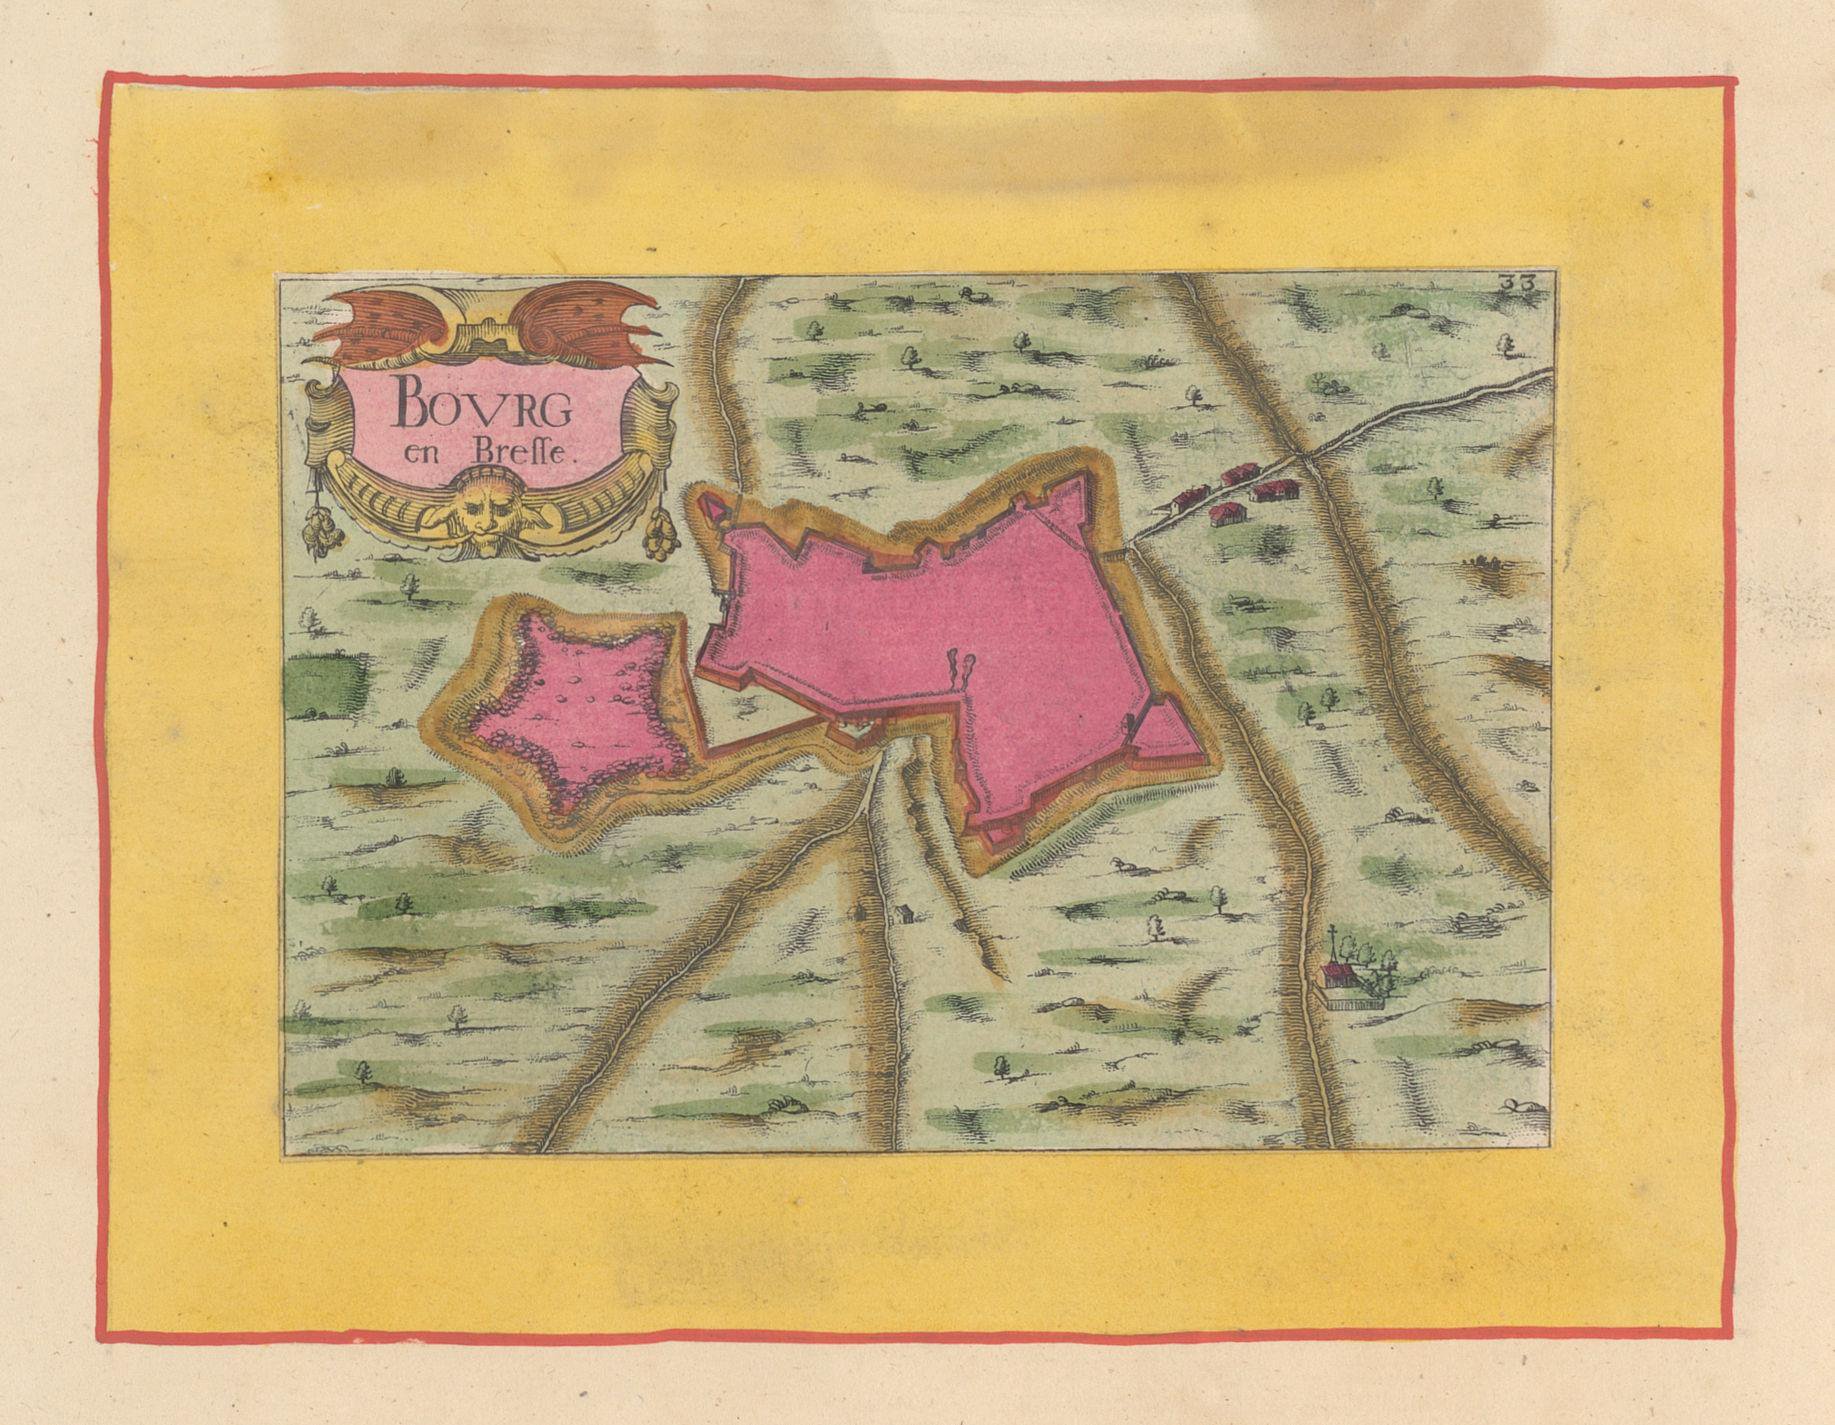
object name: print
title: Vestingplattegrond van Bourg-en-Bresse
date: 1638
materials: paper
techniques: engraving, etching, hand coloring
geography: paris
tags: maps of cities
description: Prent uit: Tassin, Christophe. Les plans et profils de toutes les principales villes et lieux considérables de France (...). Parijs: Michel van Lochom, 1638, kaart 33 uit het deel 'Dauphiné'.